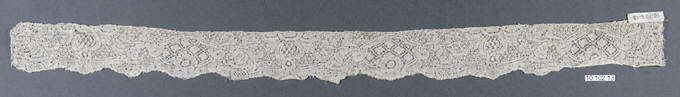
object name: fragment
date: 1601-1700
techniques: lace